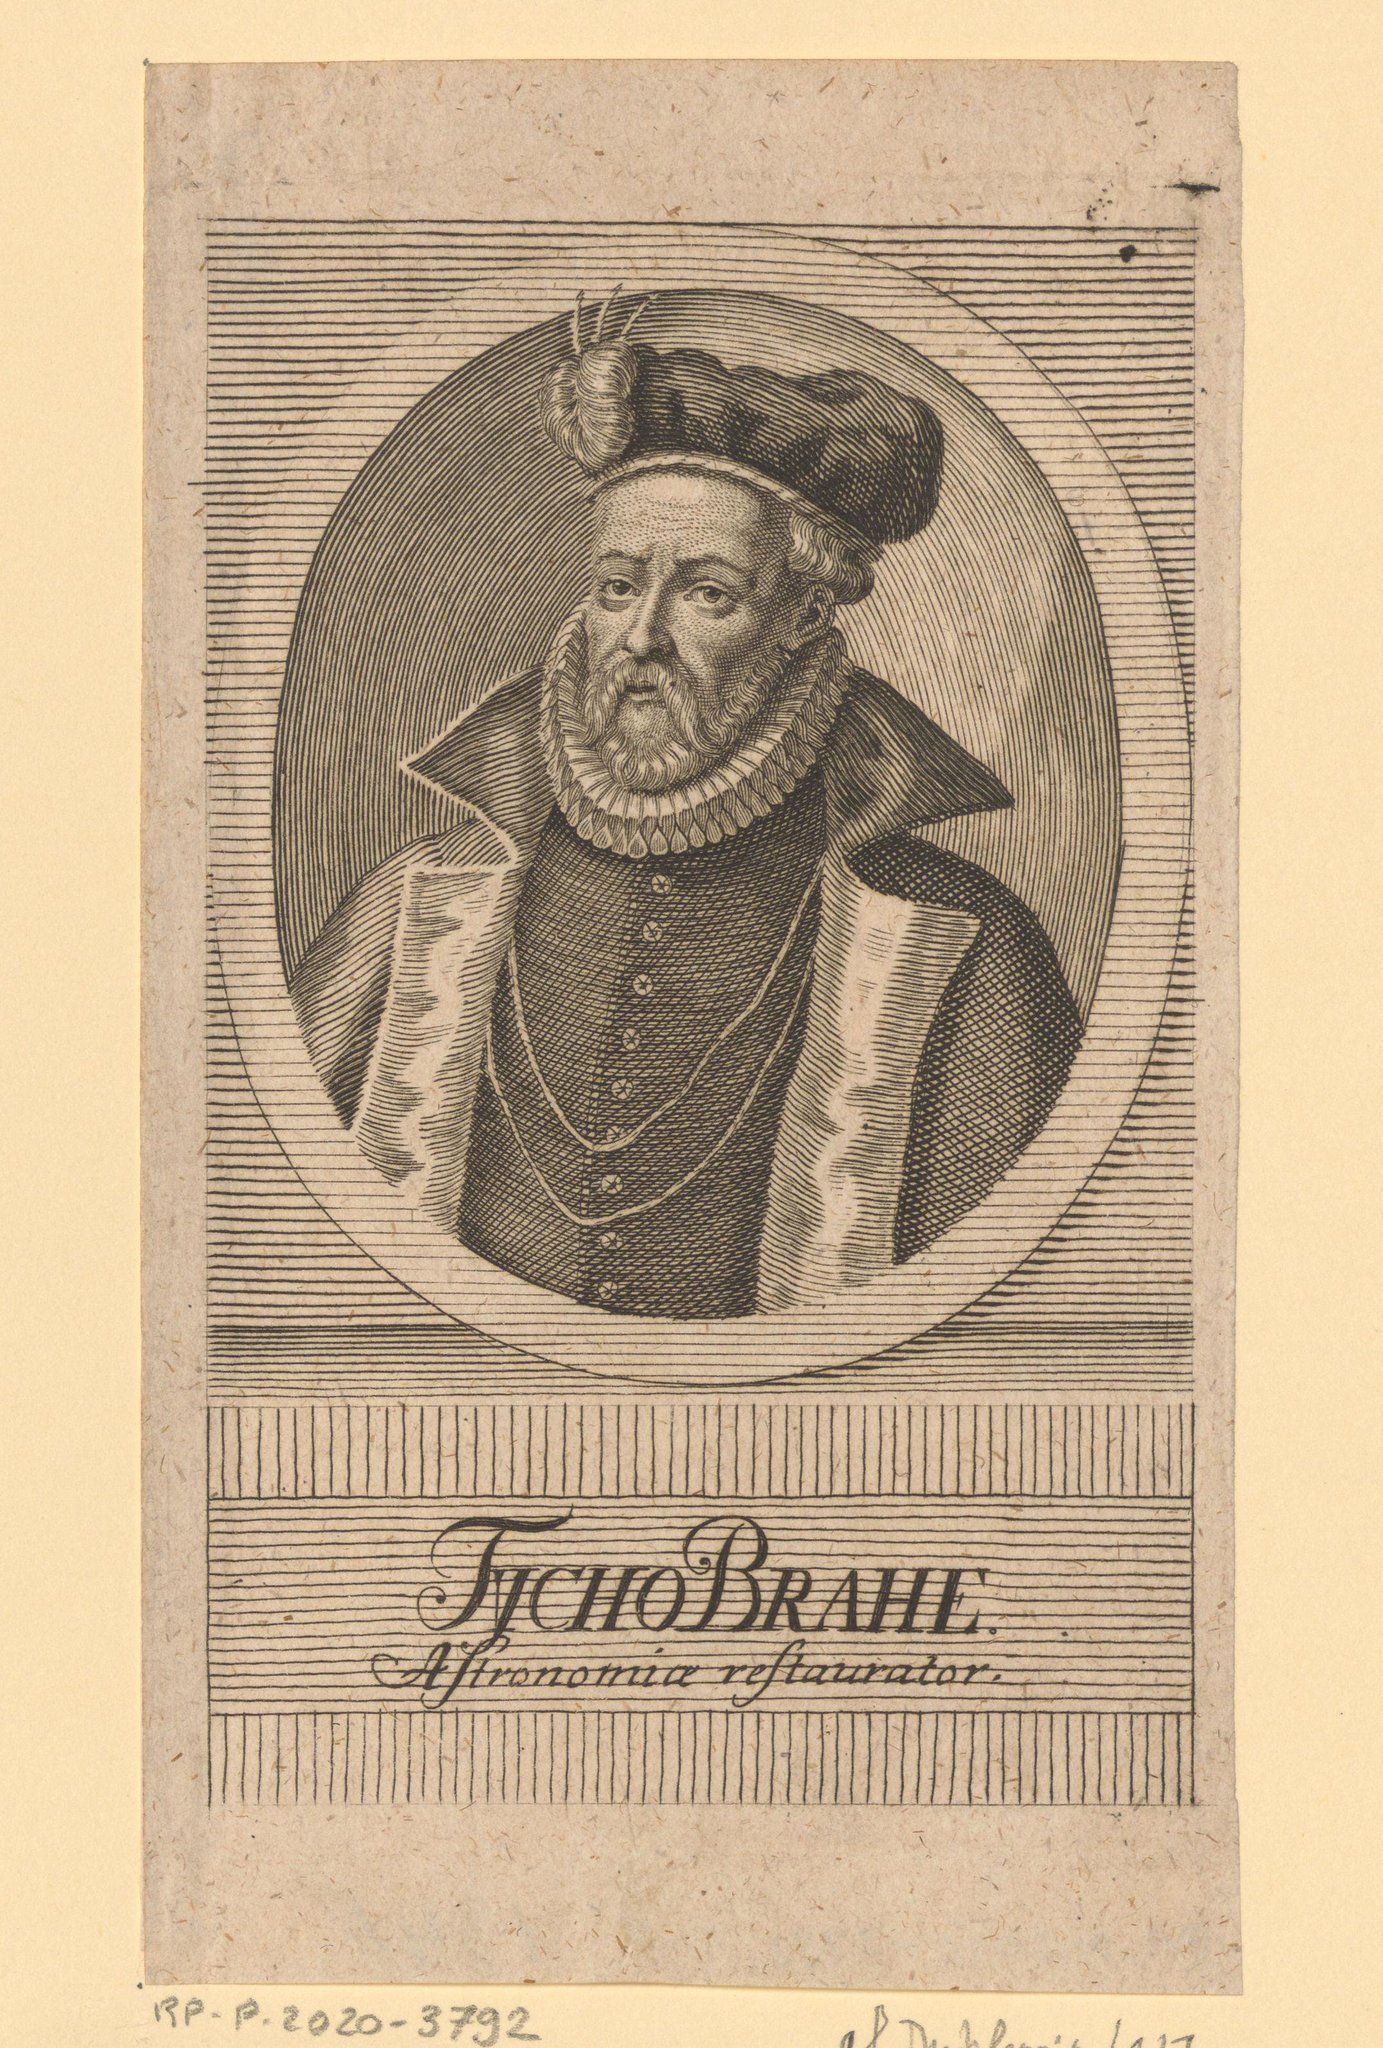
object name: print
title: Portret van Tycho Brahe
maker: Anonymous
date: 1650-1749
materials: paper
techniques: engraving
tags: prague, tycho brahe, scholar, philosopher, historical persons